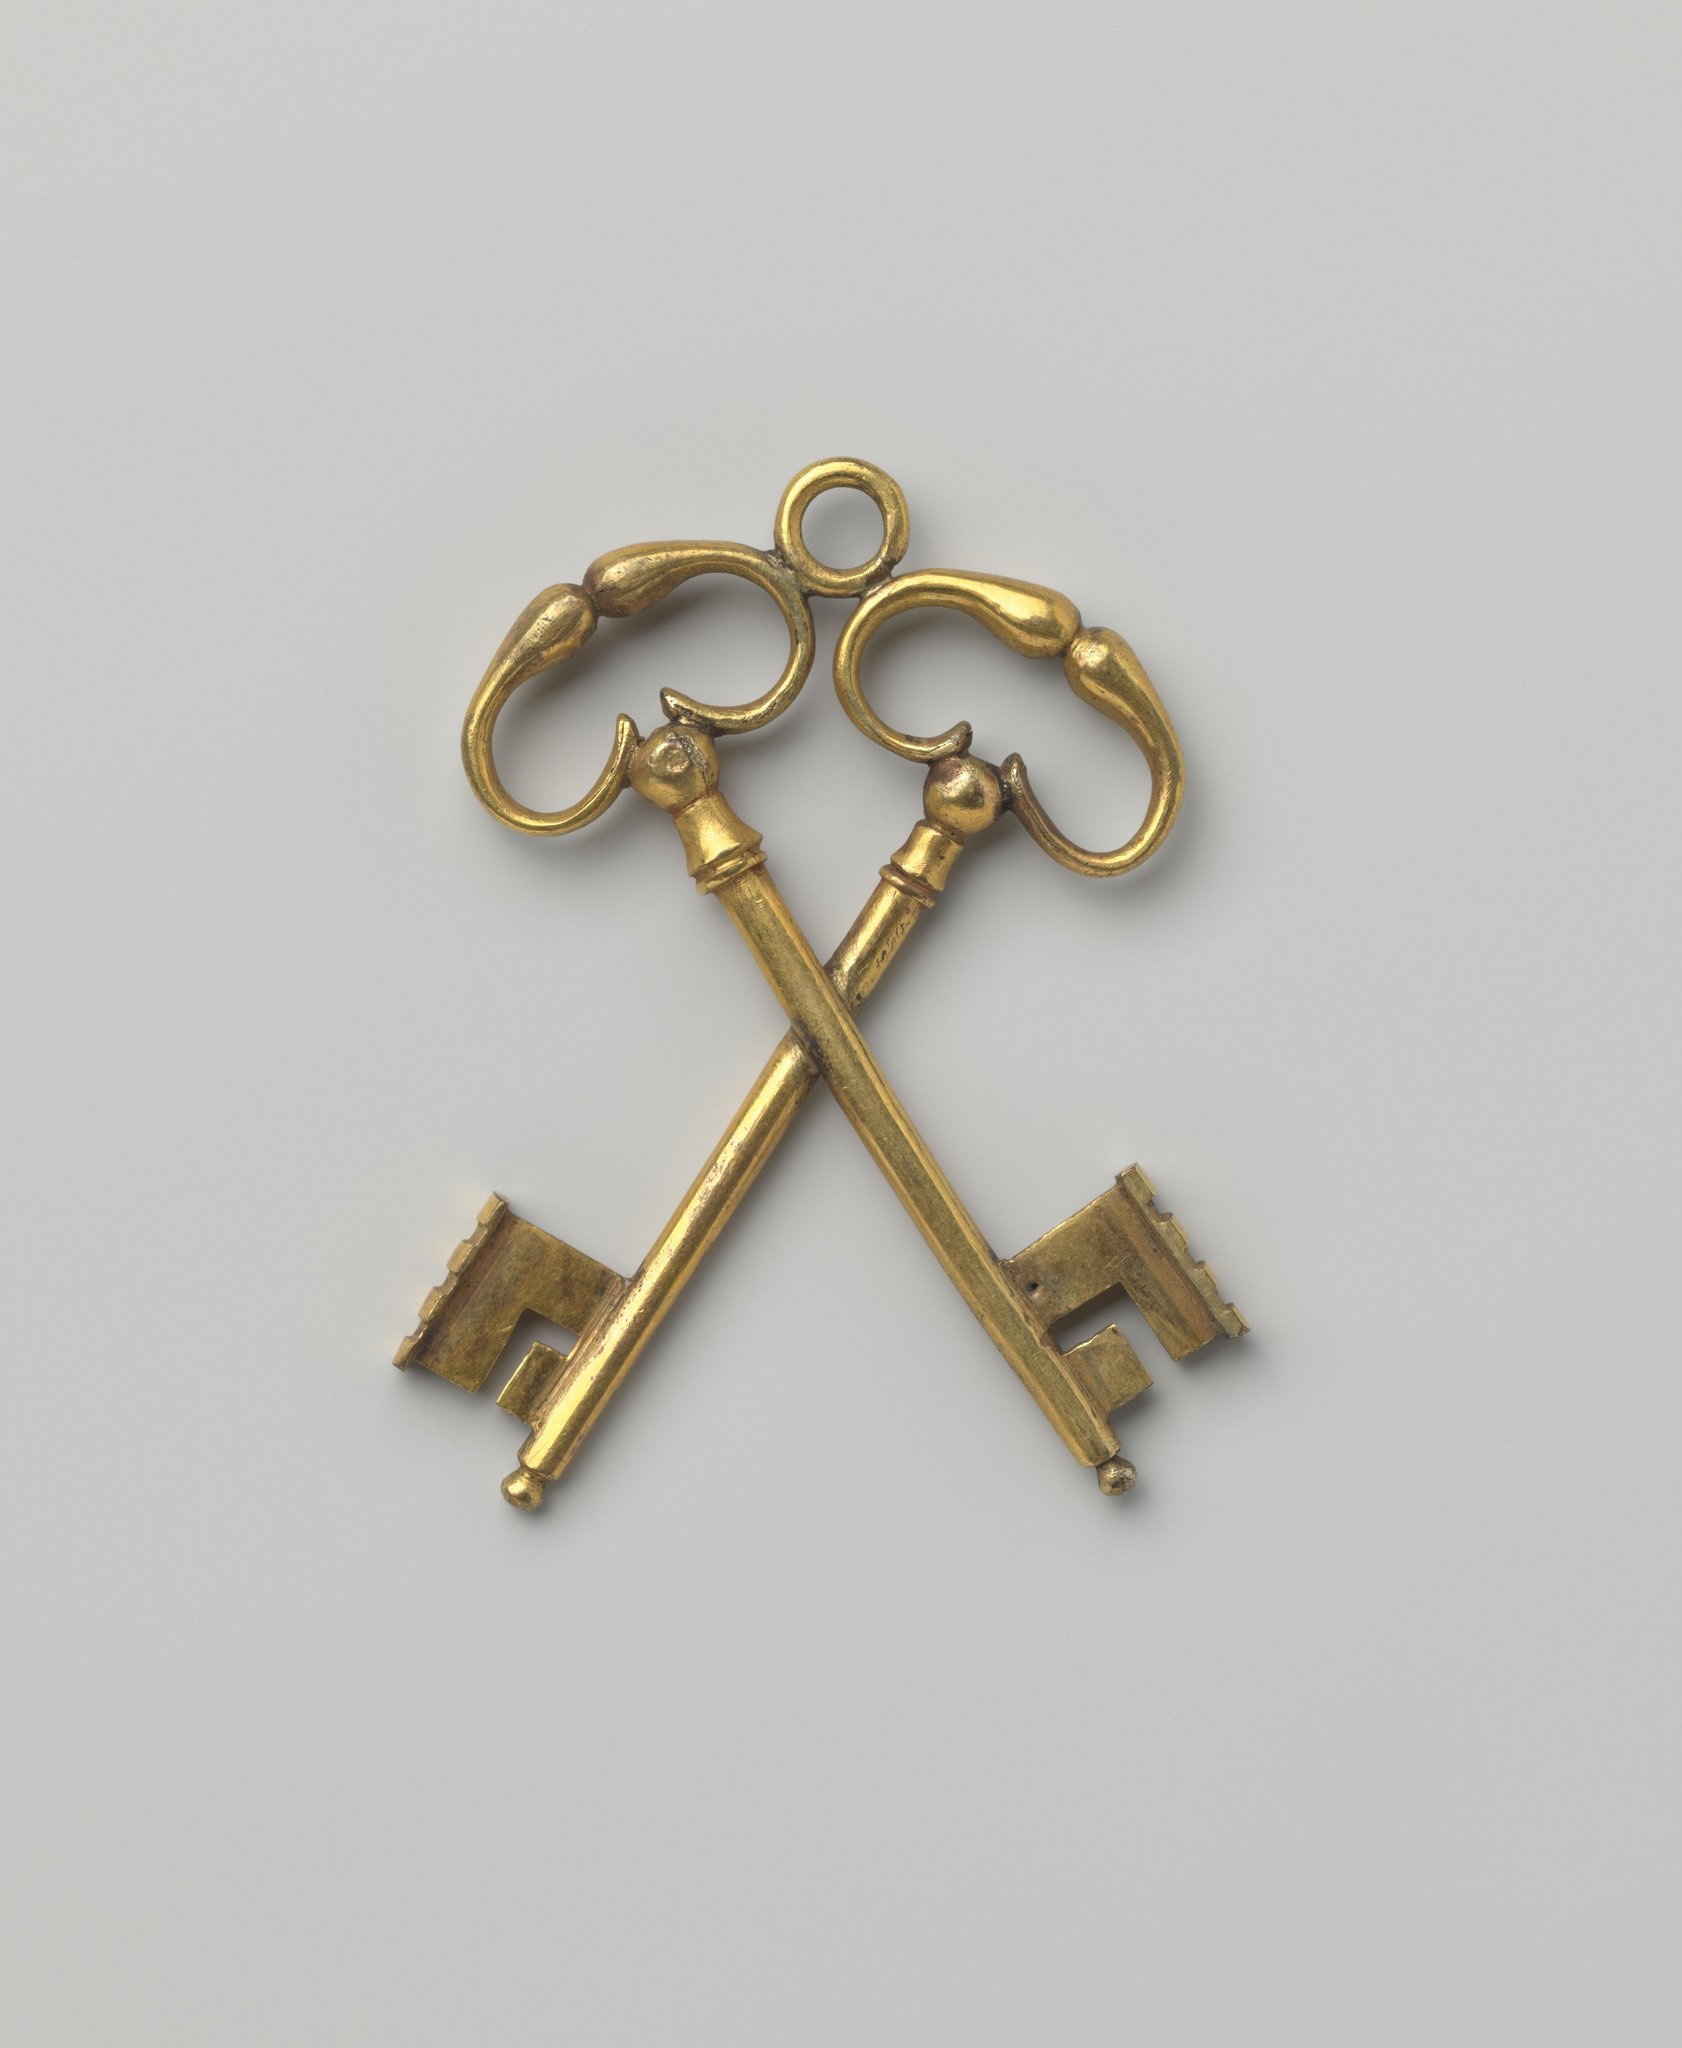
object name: key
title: Twee sleutels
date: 1700-1800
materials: copper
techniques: gilding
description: Twee gekruiste sleutels, bovenaan door een oogje verbonden.